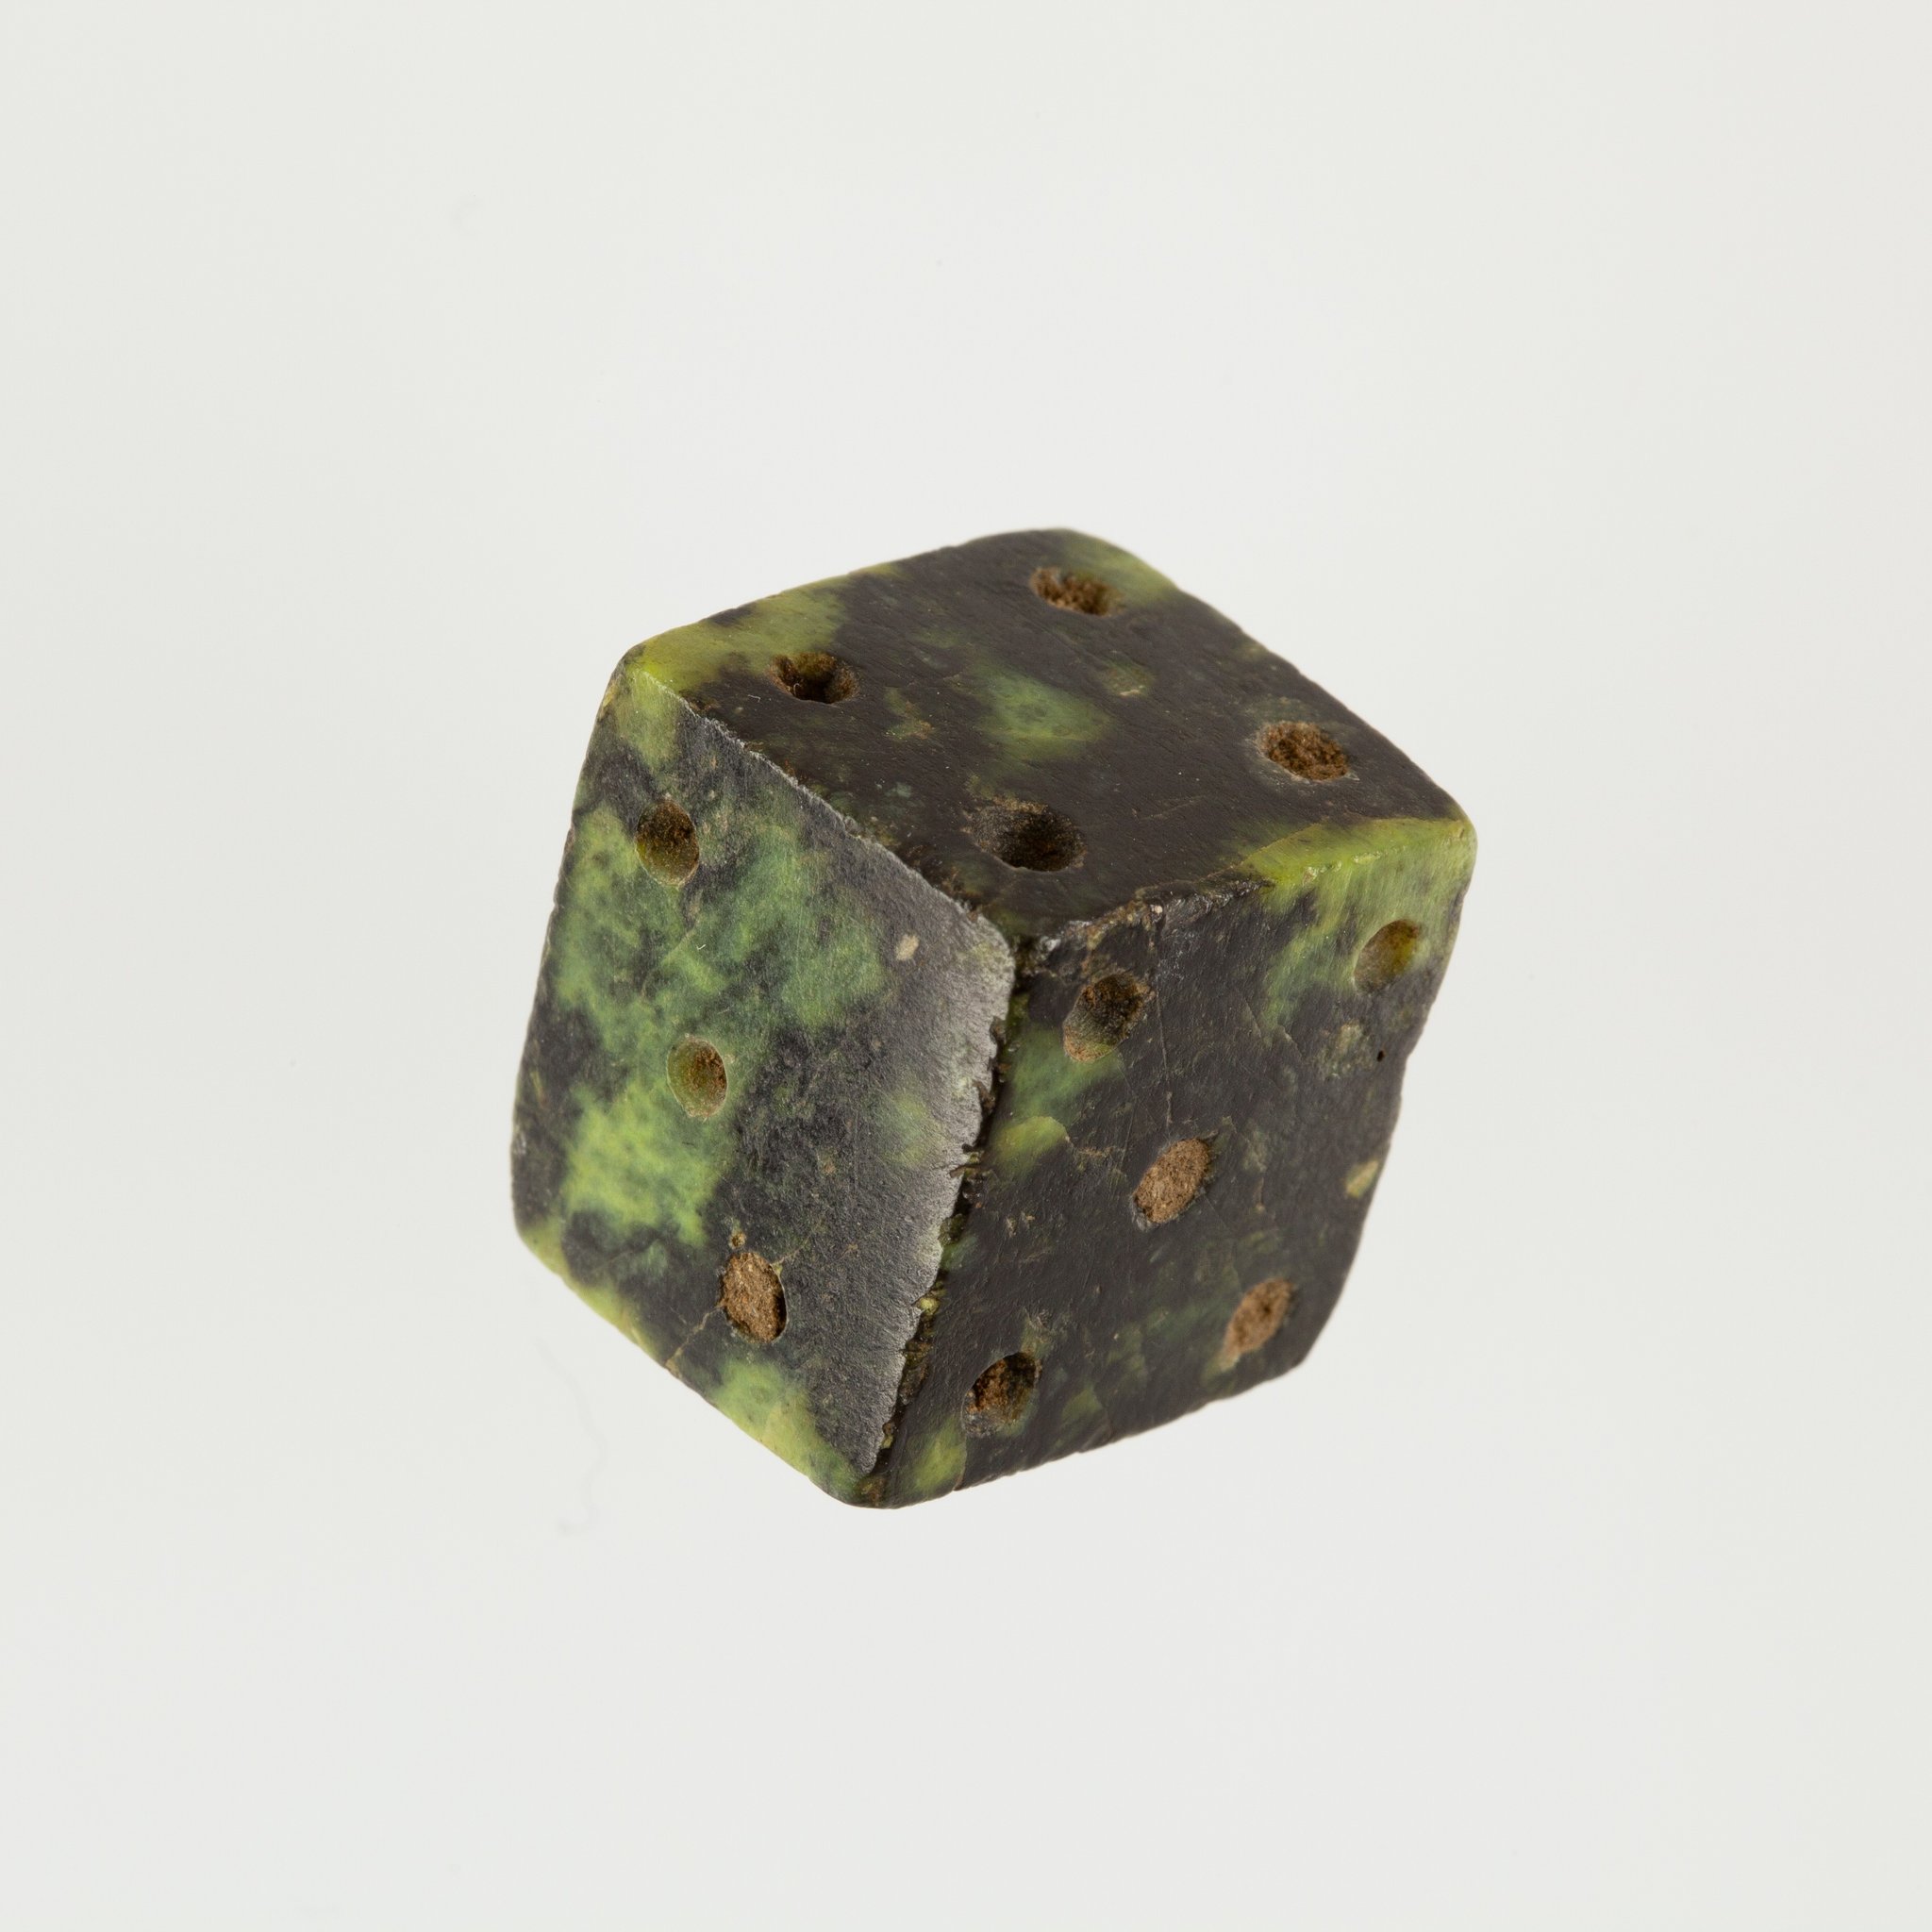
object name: die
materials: stone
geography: egypt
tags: dice